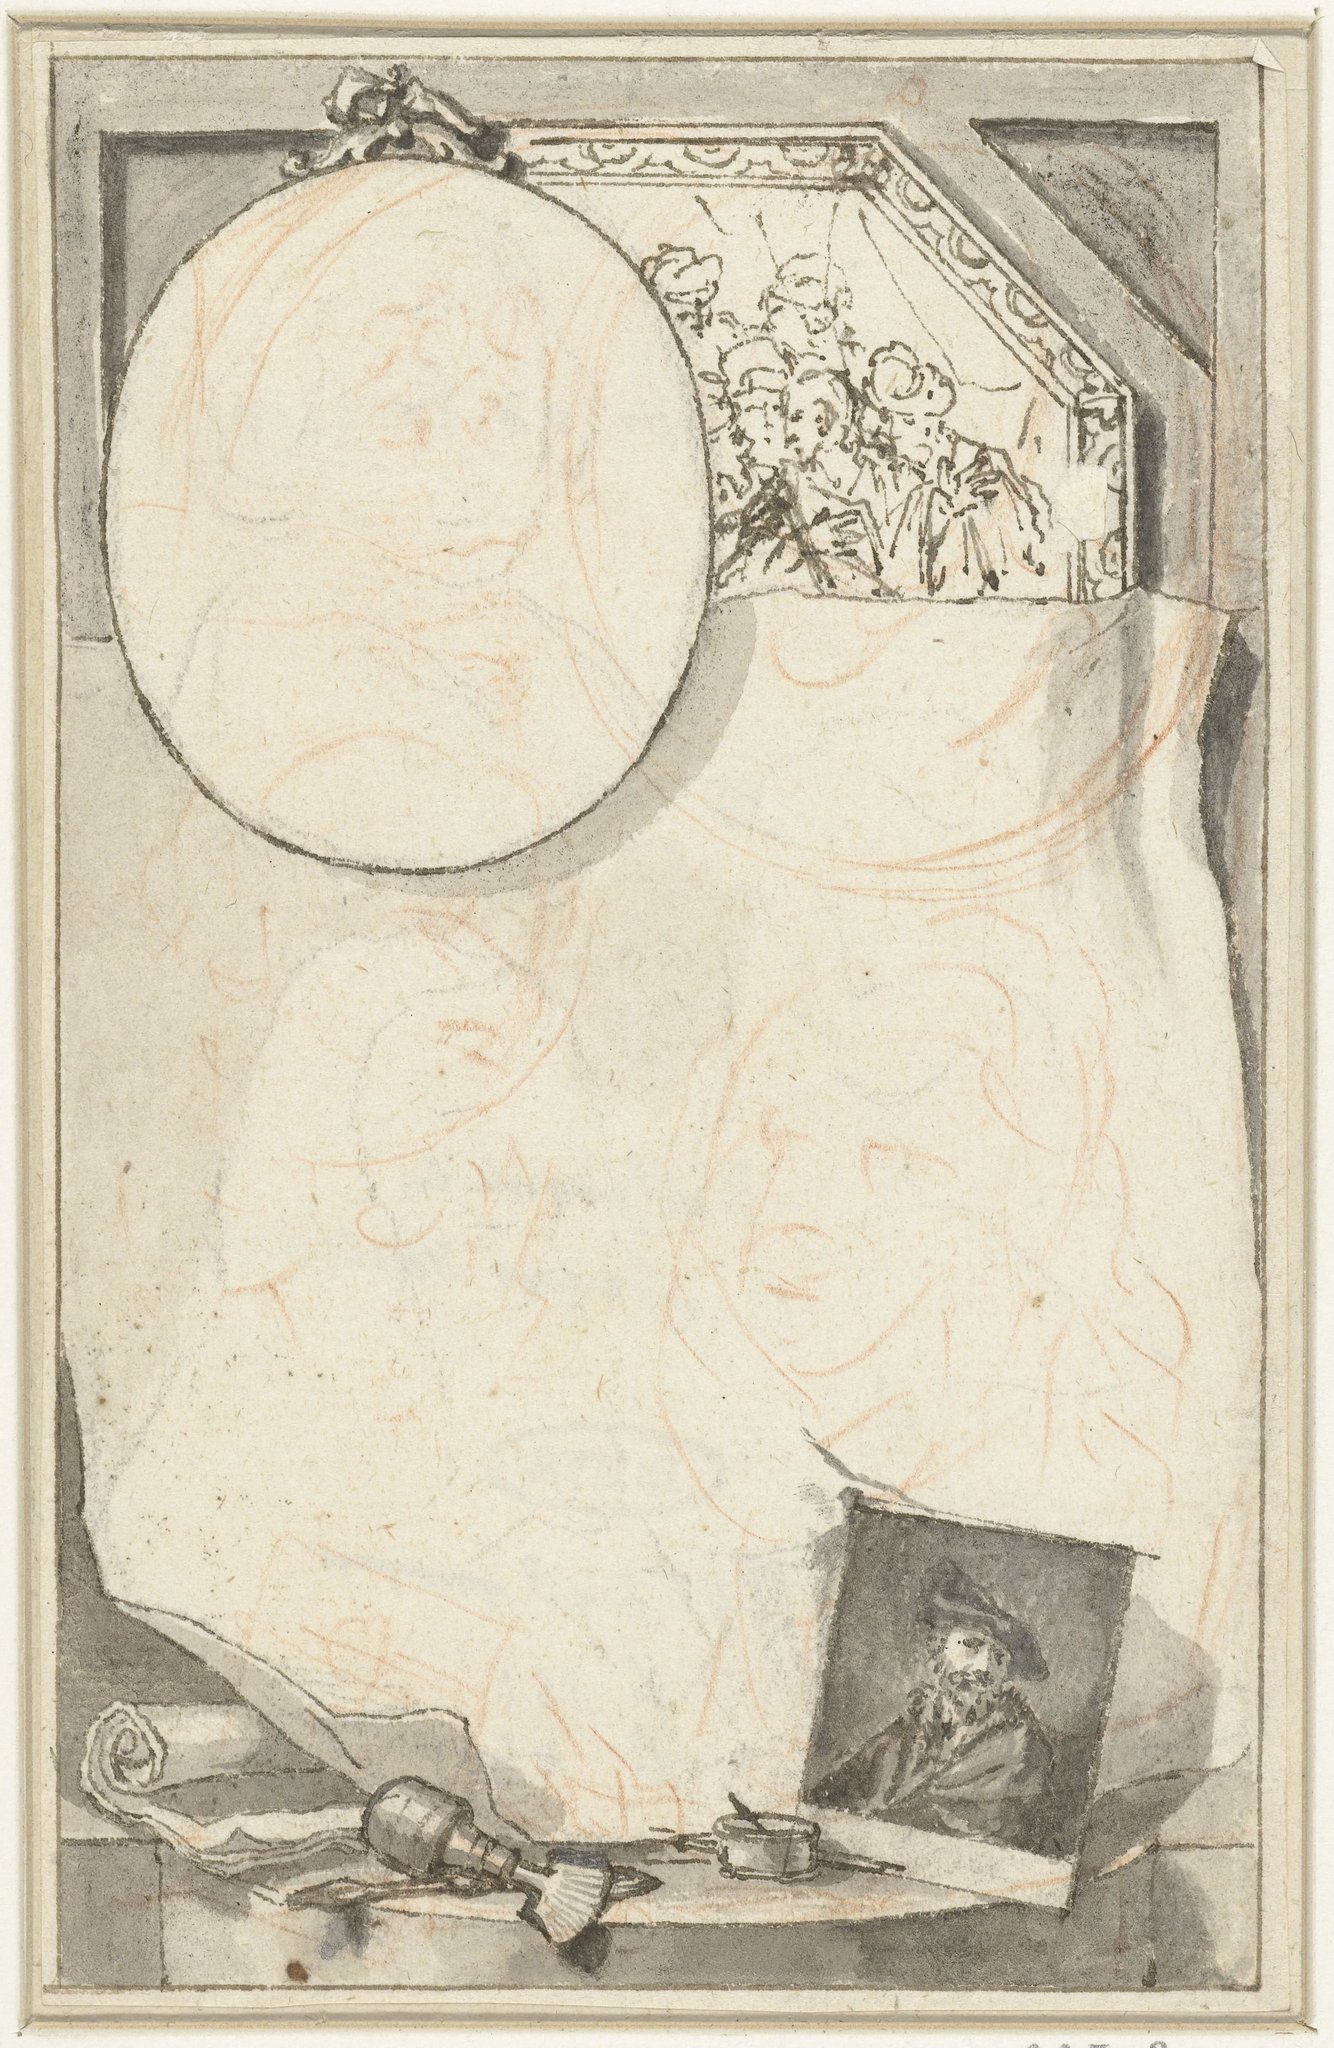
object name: design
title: Schetsen voor portretten van Gerbrand van den Eeckhout en de gebroeders Jacques en Wallerant Vaillant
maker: jacob houbraken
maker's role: draughtsman, print maker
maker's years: 1698-1780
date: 1708-1780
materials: chalk, ink, paper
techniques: brush, pen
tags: lille, amsterdam, painter, print maker, draughtsman, wallerant vaillant, gerbrand van den eeckhout, jacques vaillant